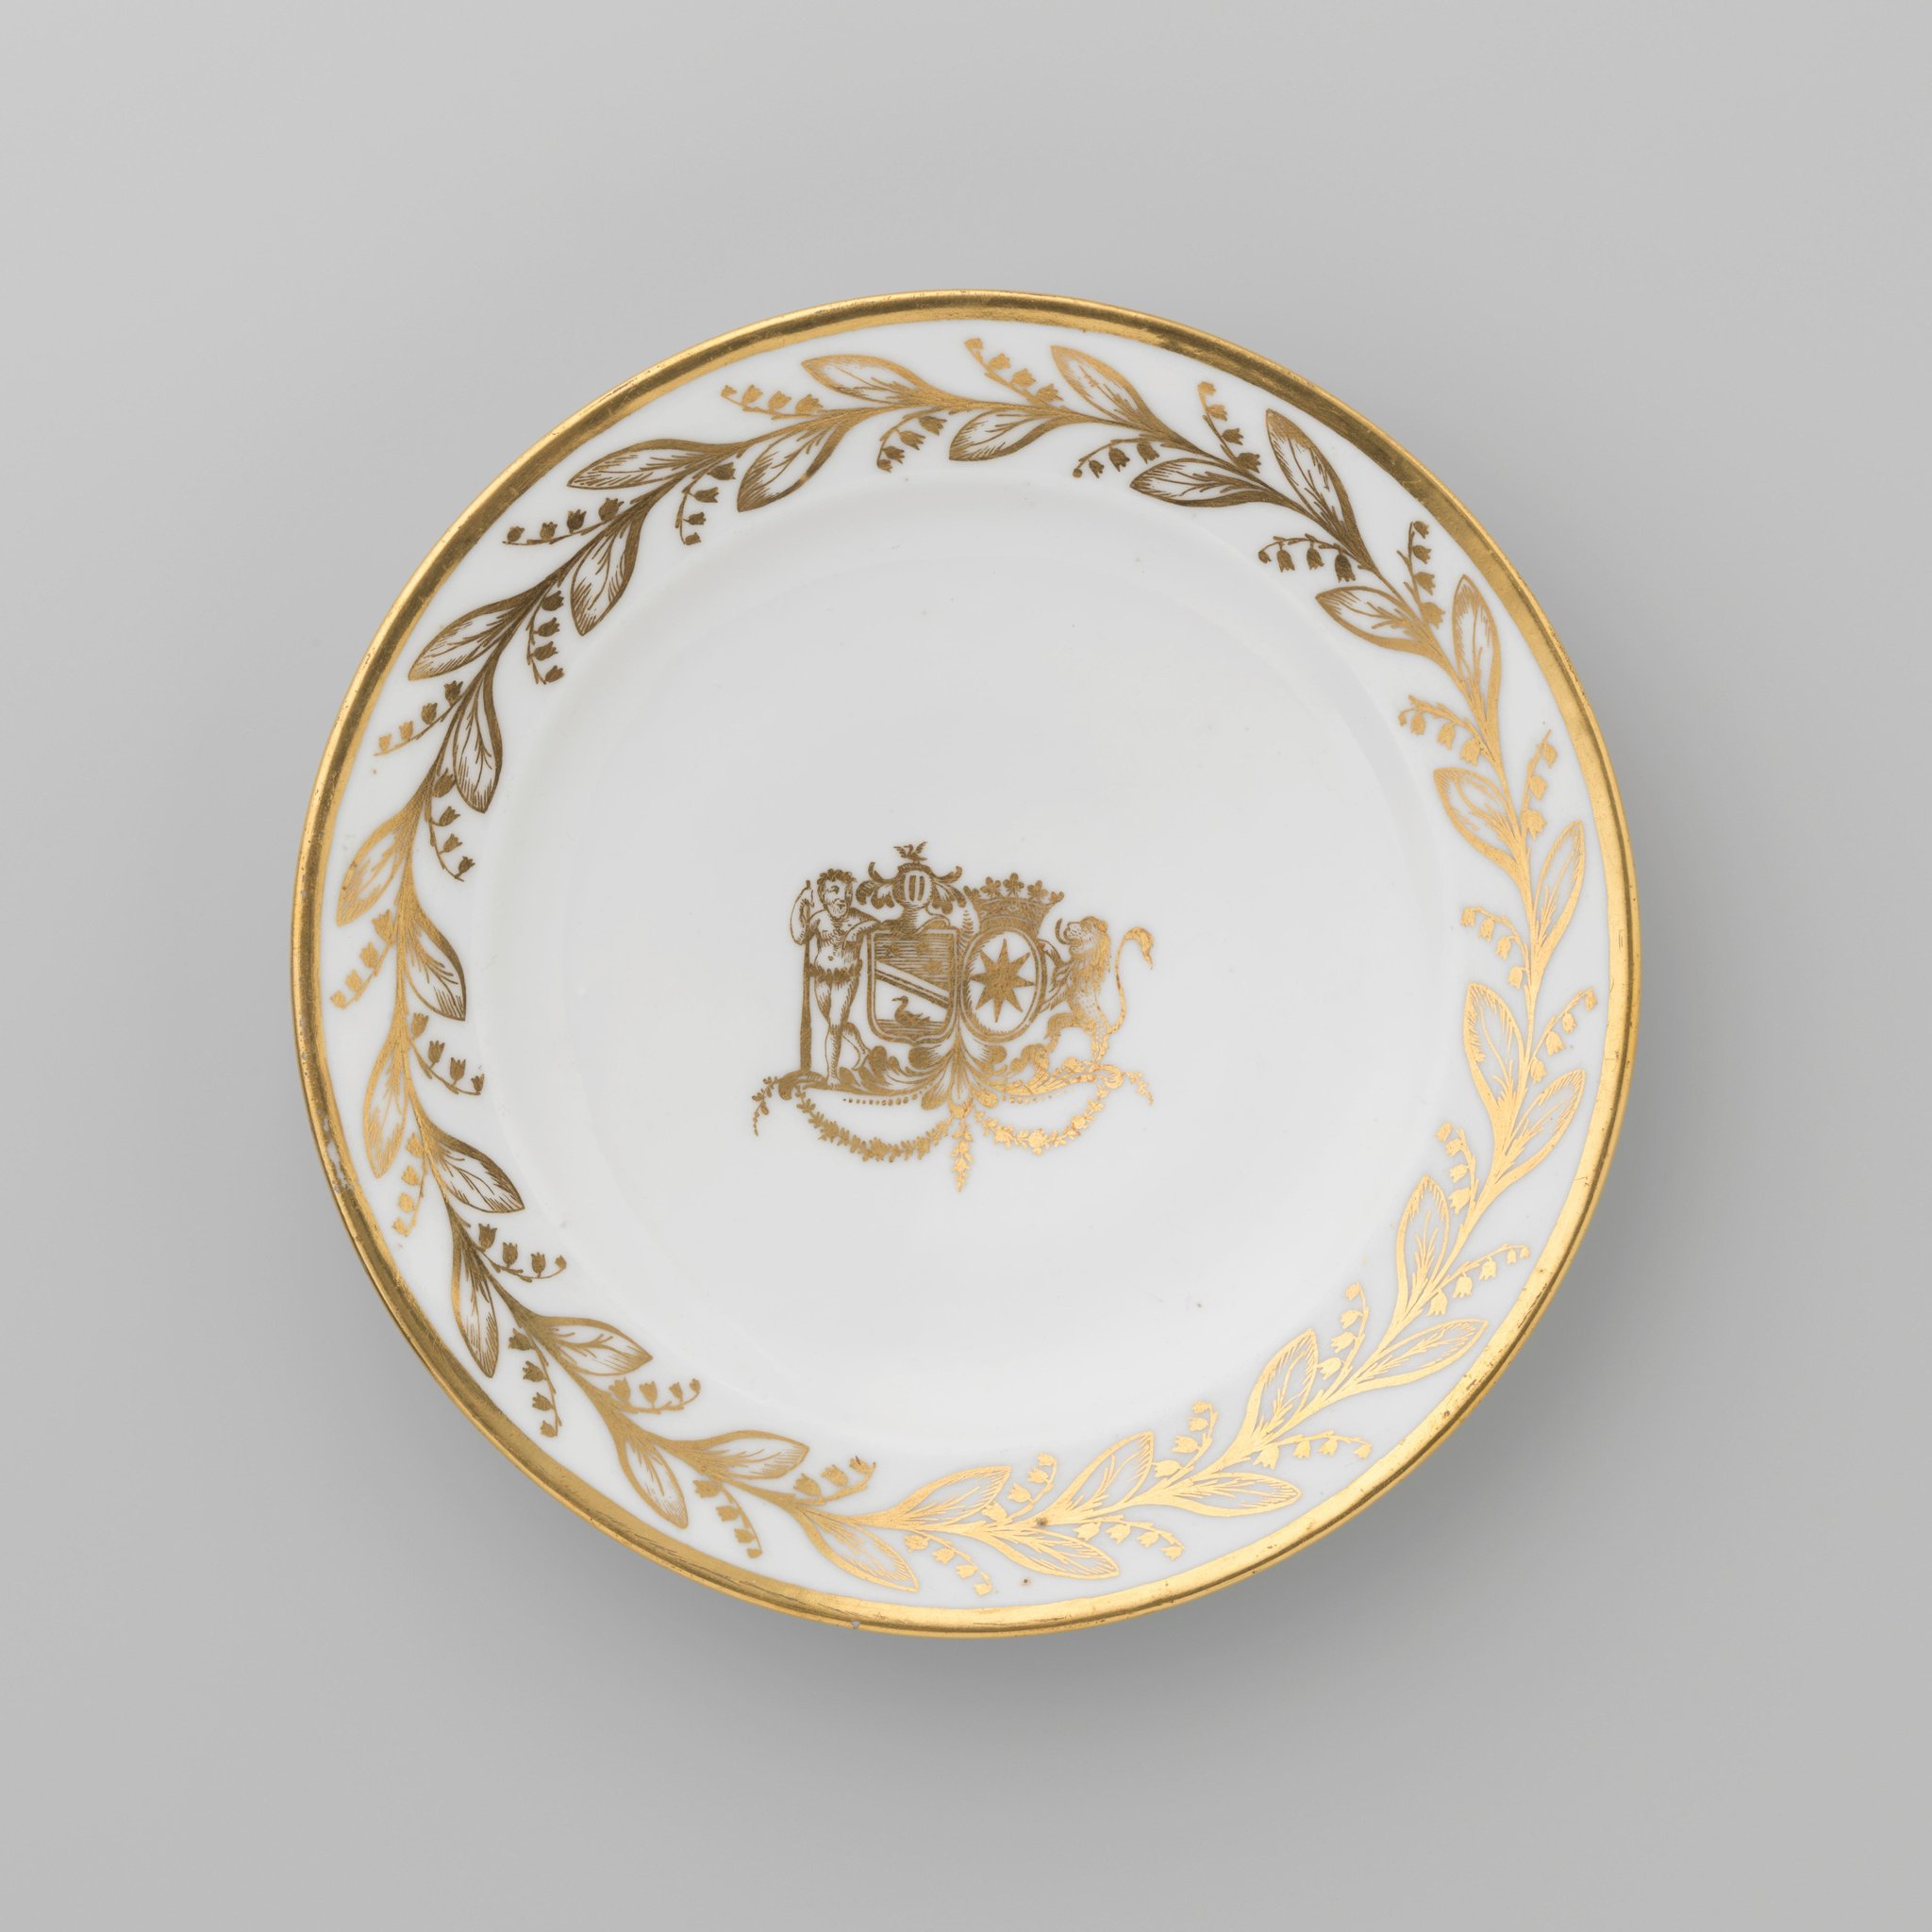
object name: service set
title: Plate with the coat of arms of Hendrik Peter Godfried Quack and Isabella Gertraud von Carnap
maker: Anonymous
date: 1790-1800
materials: glaze, gold, paint, porcelain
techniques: firing, forming, gilding, turning, vitrification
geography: netherlands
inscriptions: mark: ‘N’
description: Bord van porselein, beschilderd op het glazuur met goud. Op het plat het alliantiewapen van Hendrik Peter Godfried Quack en Isabella Gertraud von Carnap. De rand met een bloemrank en een gouden band. Een proen op de onderzijde. Gemerkt op de onderzijde met N.